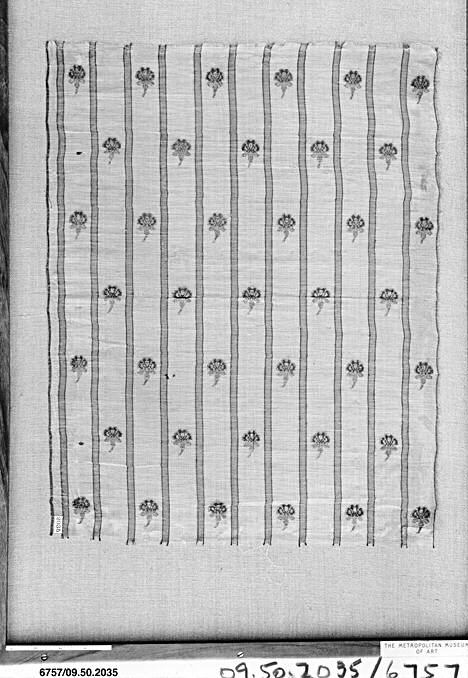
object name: textile fragment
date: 1801-1900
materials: metal thread, silk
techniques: brocade, weave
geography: india